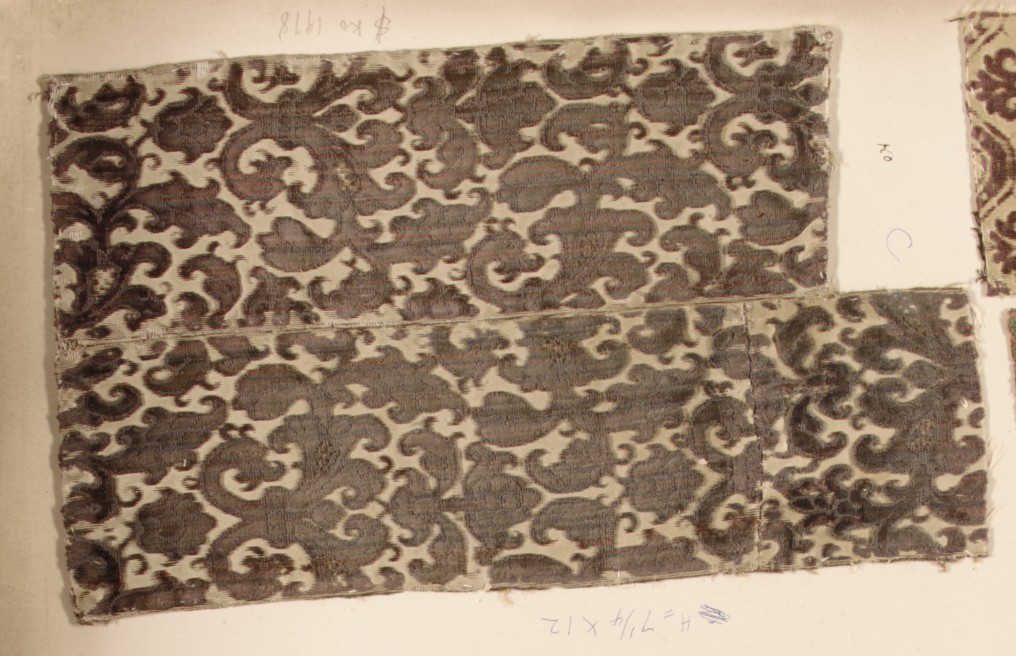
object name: fragment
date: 1567-1600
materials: silk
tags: leaves